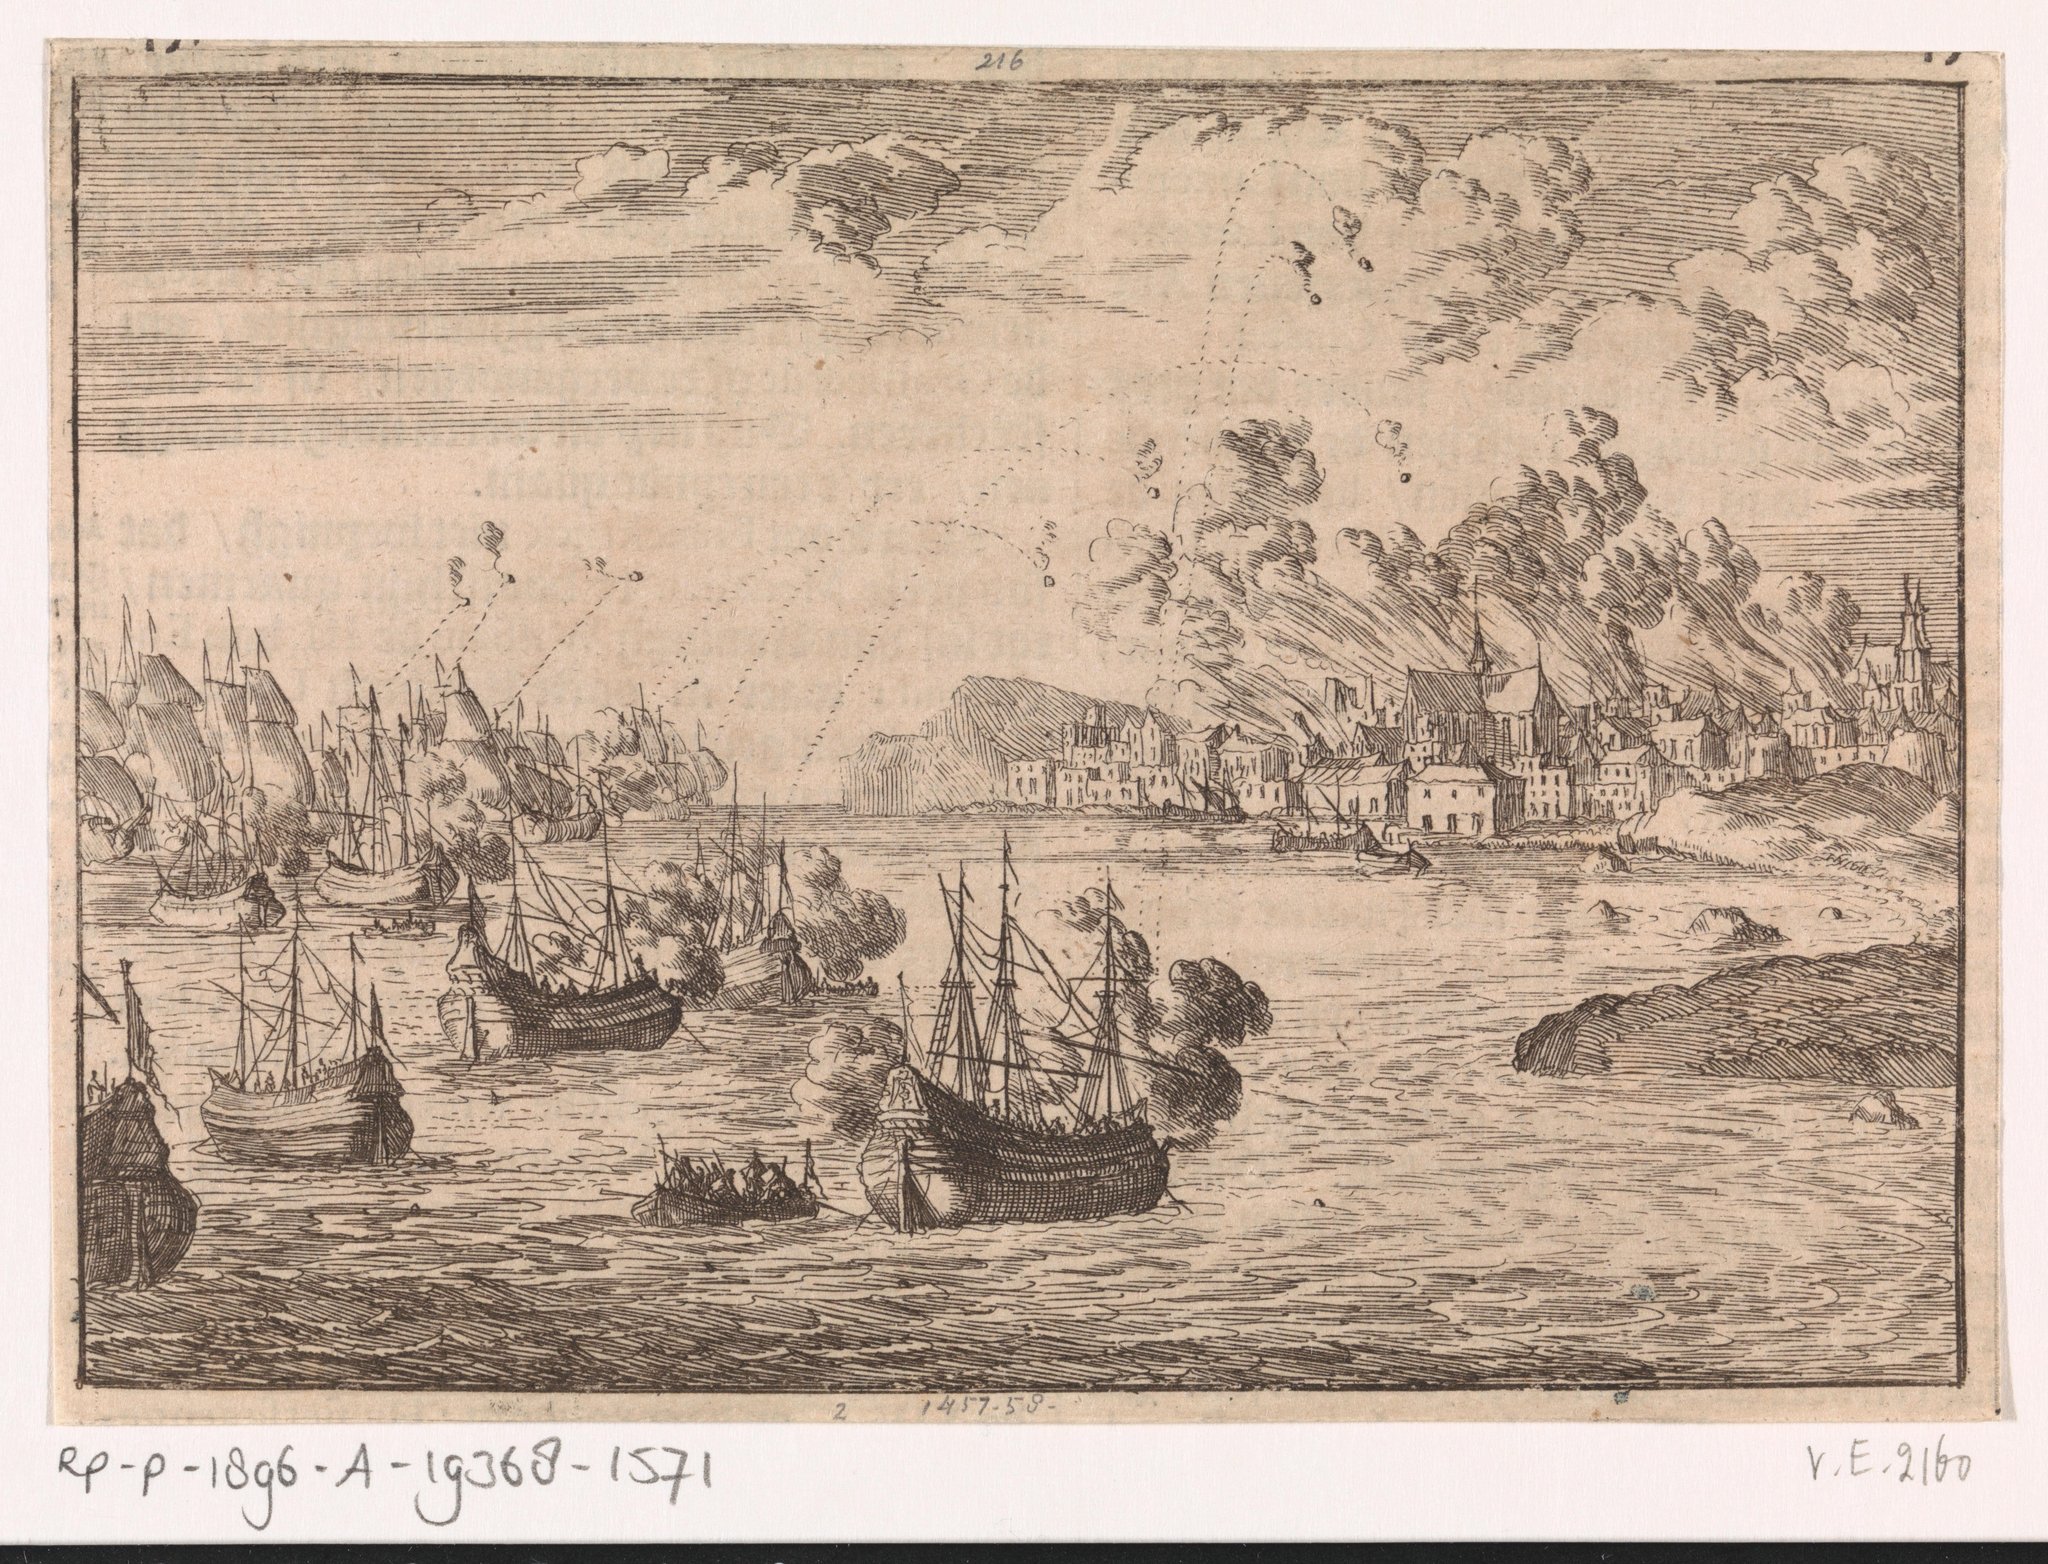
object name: book illustration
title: Bombardement van Dieppe, 1694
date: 1698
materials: paper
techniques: etching, letterpress printing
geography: amsterdam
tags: maps of cities, bombardment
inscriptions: collector's mark: Lugt 2228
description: Illustratie uit: Gottfried, Johann Ludwig. Historische kronyck; vervattende een (...) beschrijvingh der aldergedenckwaerdigste geschiedenissen des weerelds, van den aenvangh der scheppingh tot (...) 1576 (2 delen). Leiden: Pieter van der Aa, 1698, dl. II, p. 1457.